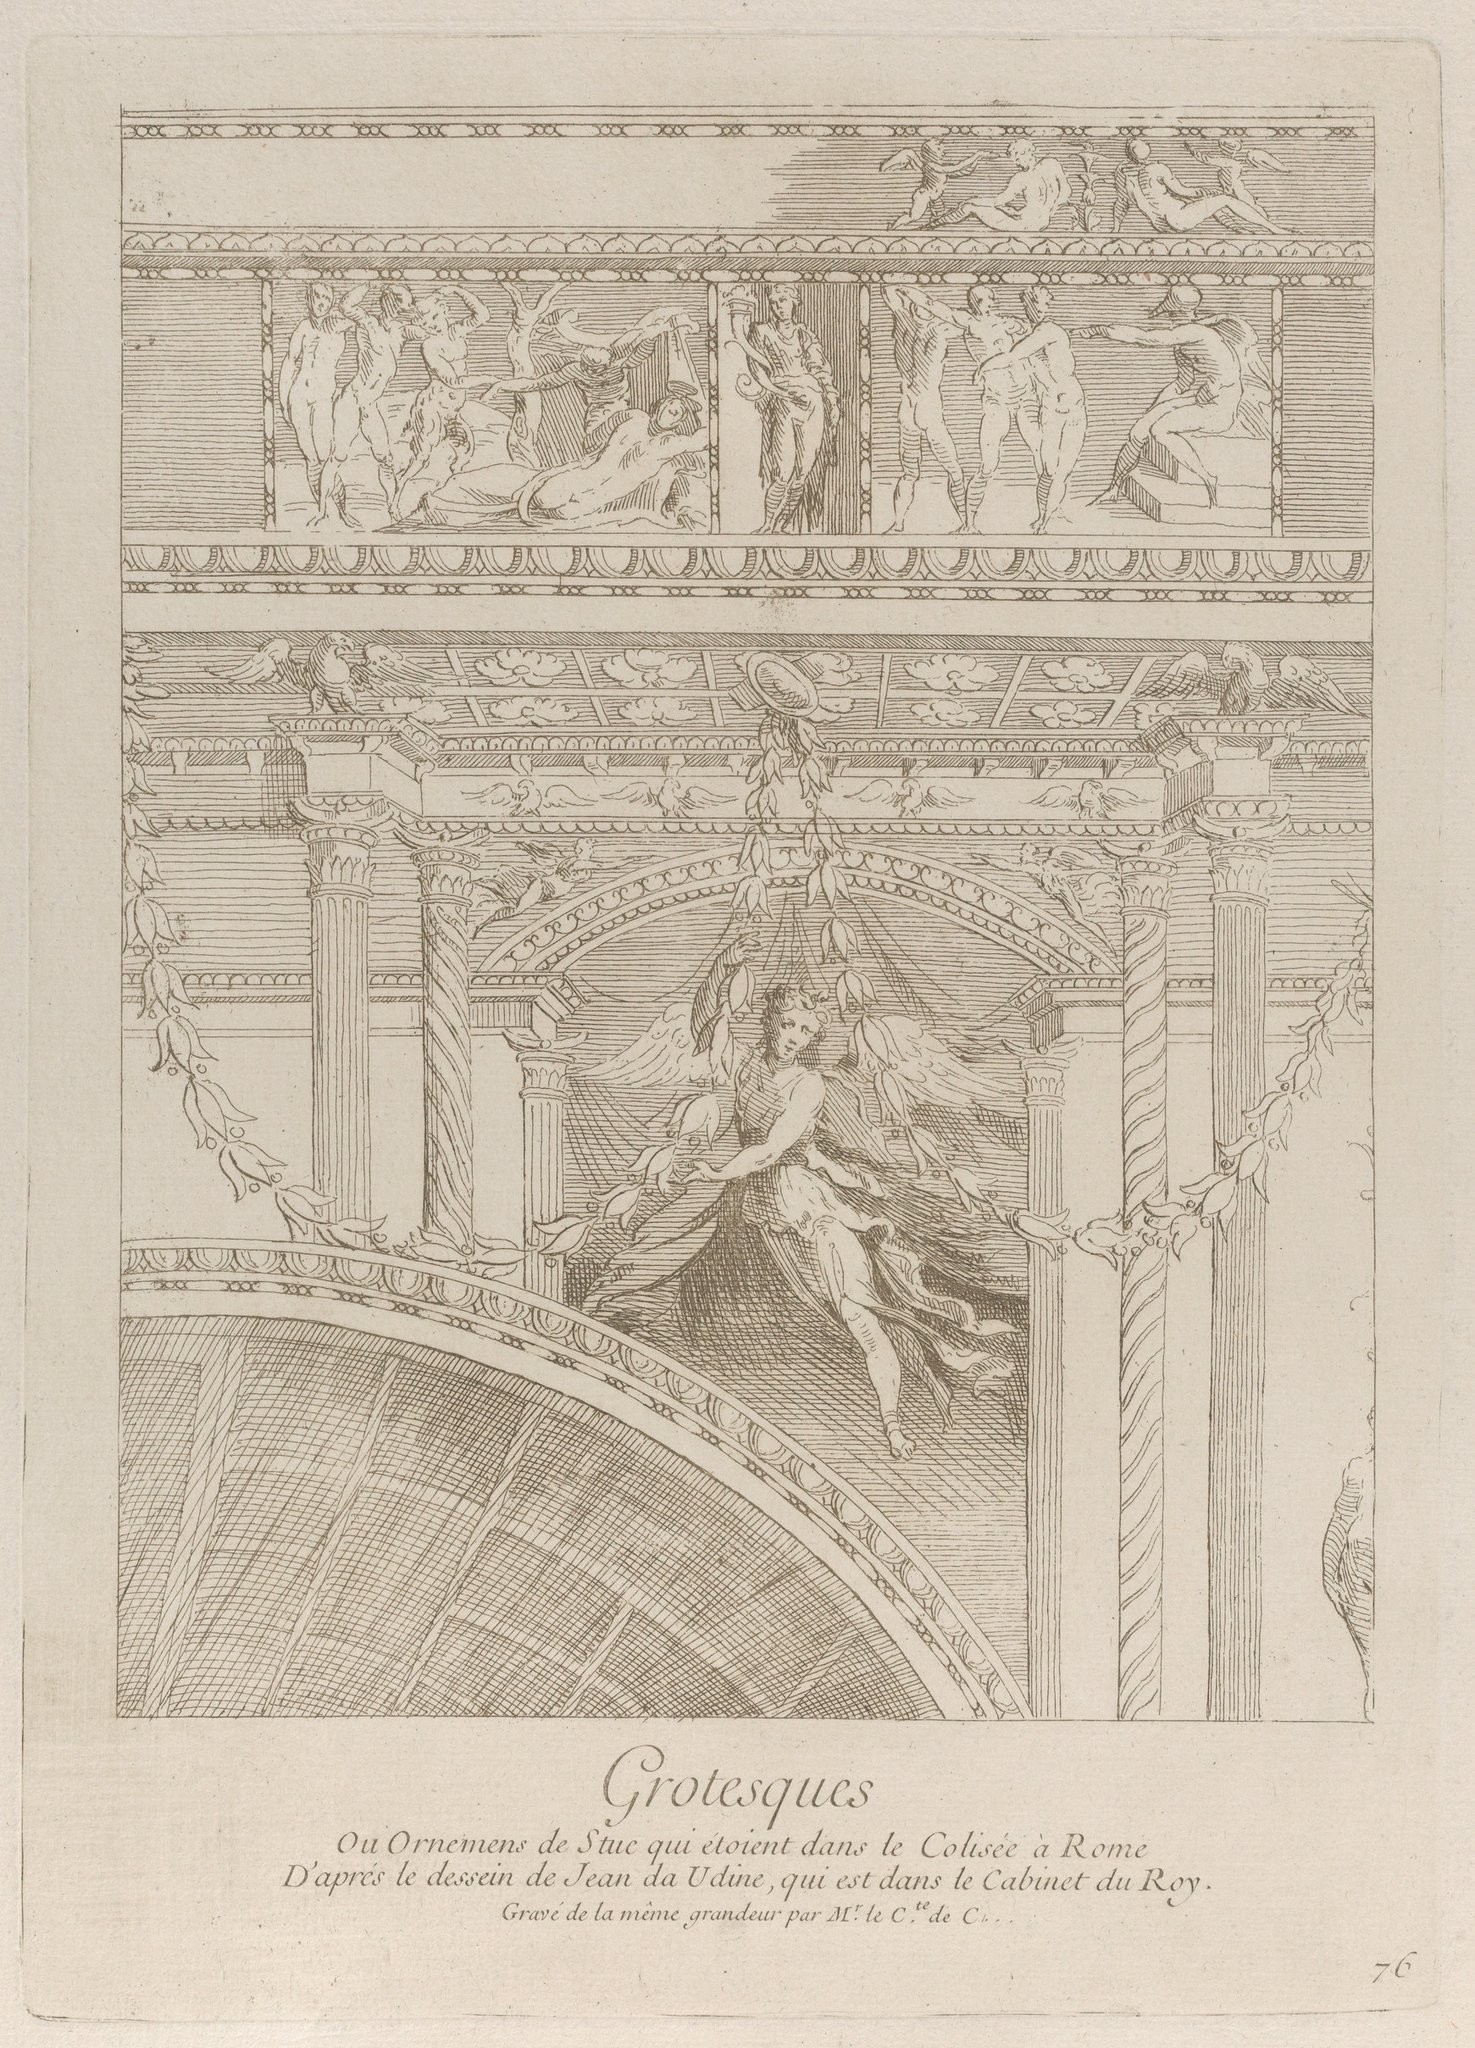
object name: print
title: Grotesques: detail of the stucco reliefs decorating the Colosseum in Rome, with a winged figure hovering between two pairs of columns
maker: anne claude philippe de tubières, comte de caylus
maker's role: artist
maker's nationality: french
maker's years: 1692-1765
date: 1729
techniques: etching